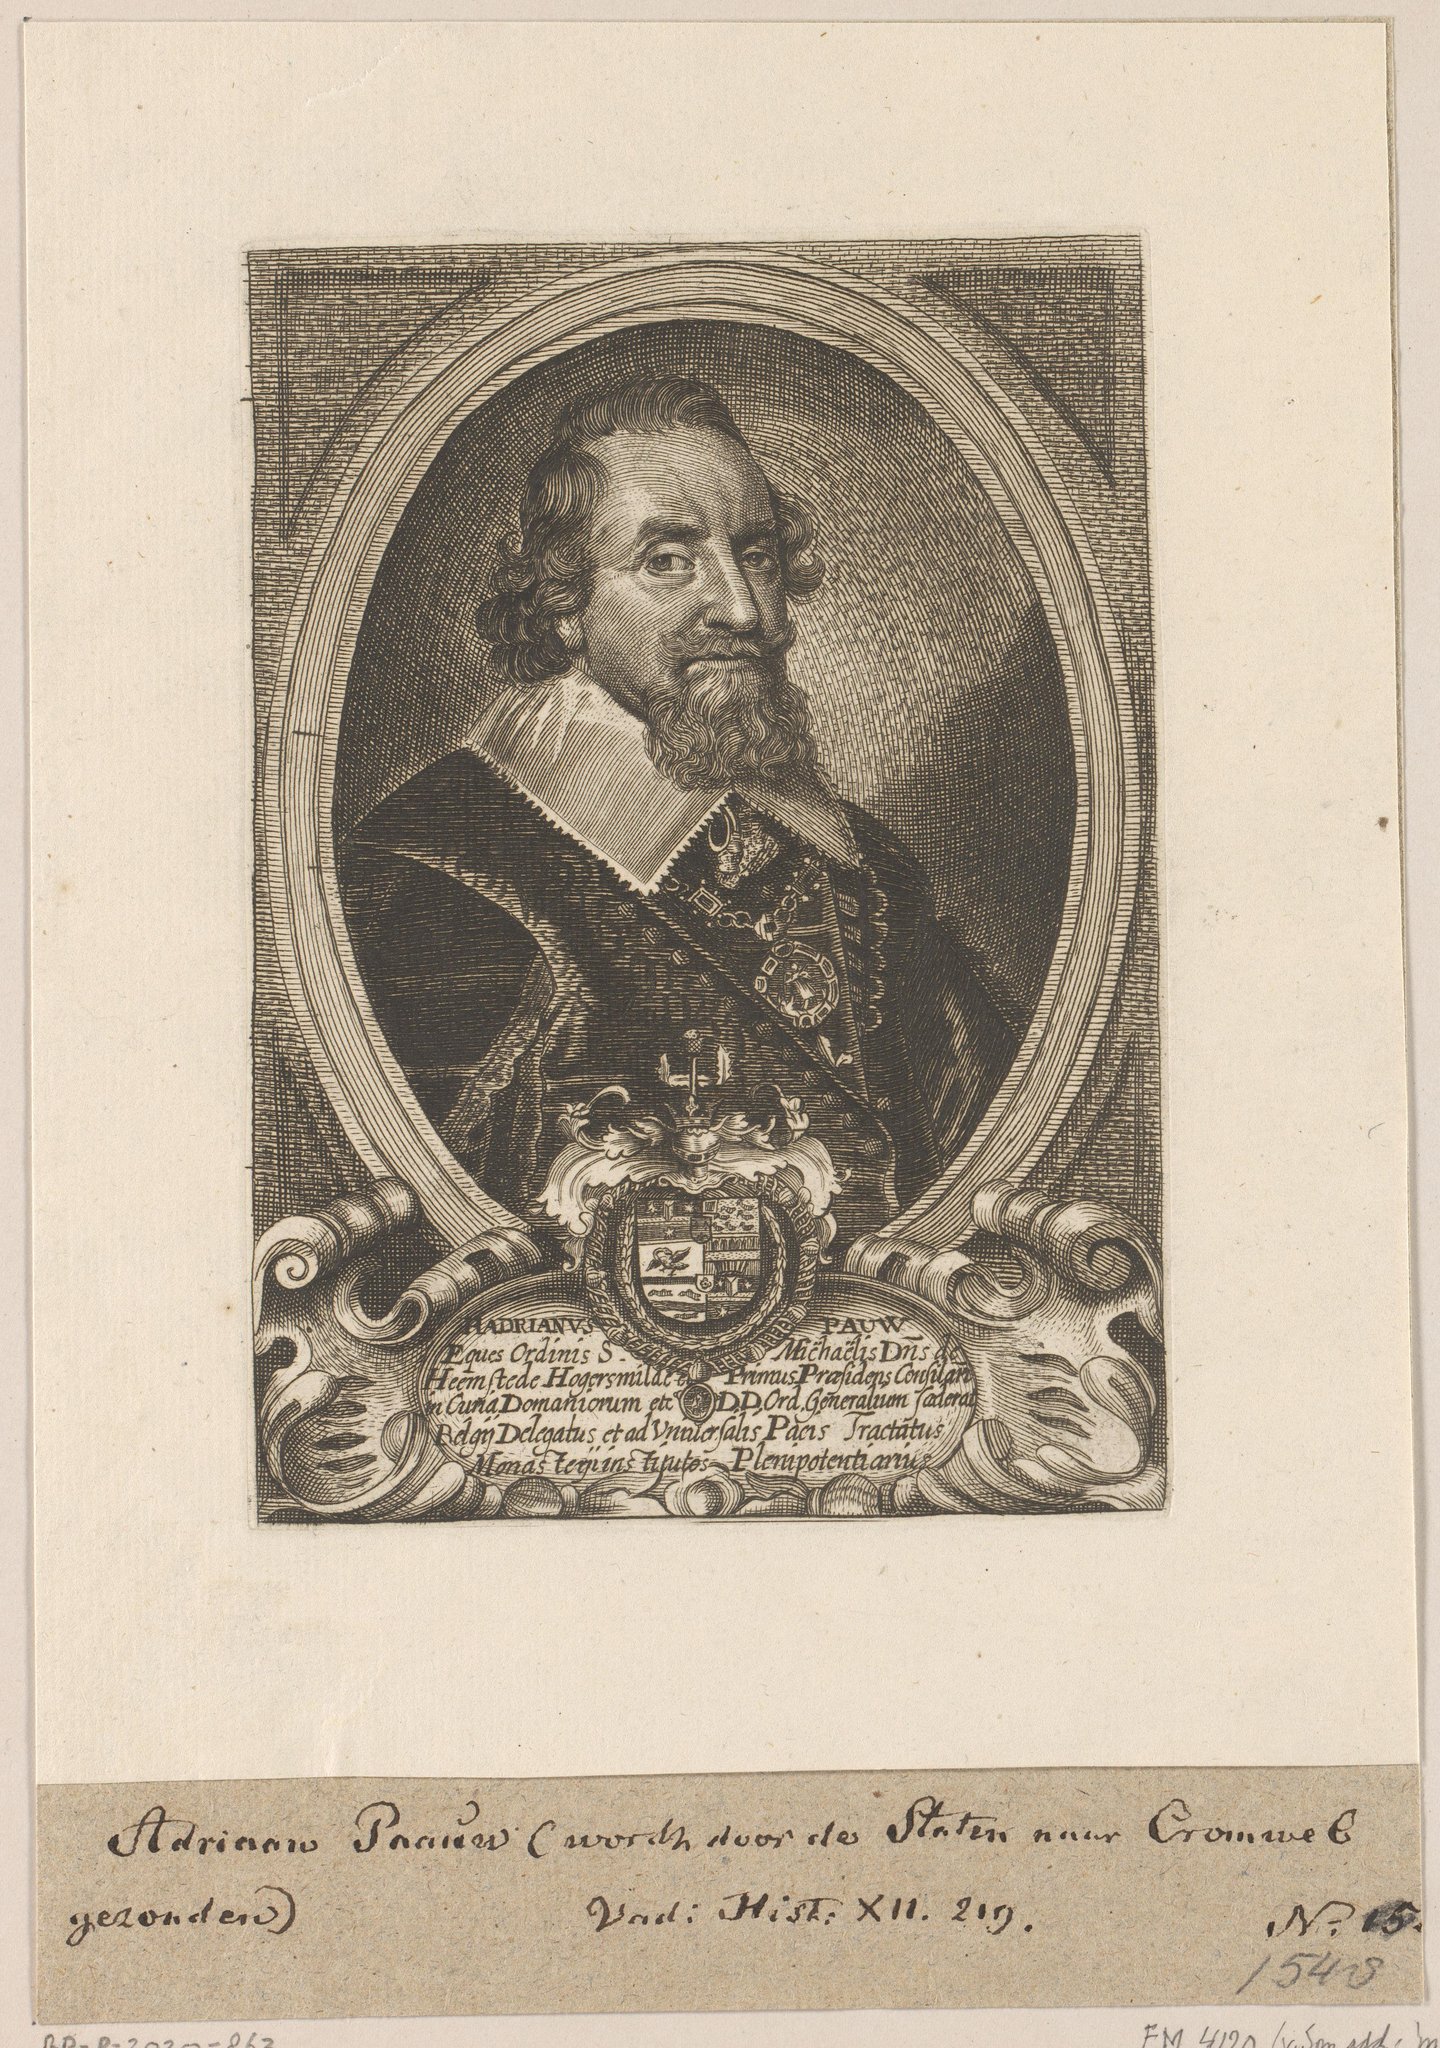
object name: print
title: Portret van Adriaen Pauw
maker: Anonymous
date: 1600-1699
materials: paper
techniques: engraving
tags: the hague, politician, adriaen pauw (1585-1653), official; civil servant; functionary (in general), historical persons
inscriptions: inscription: ‘Adriaan Paauw (wordt door de Staten naar Cromwel gezonden)’